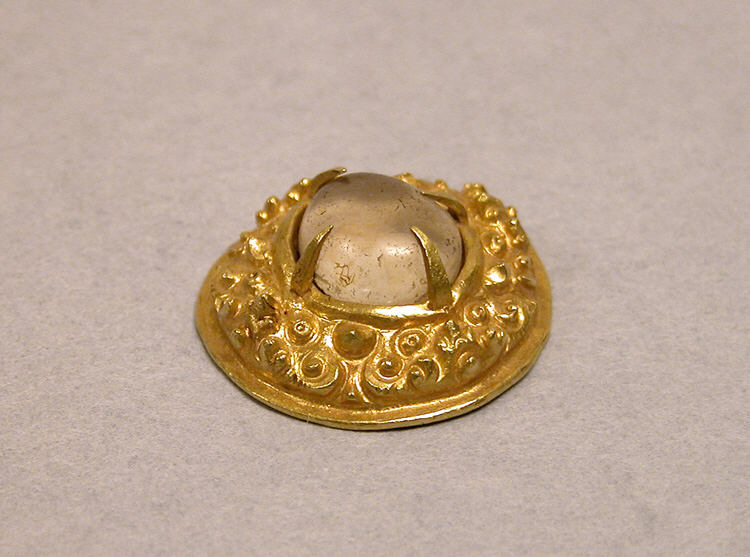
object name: ornament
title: Ornament with Crystal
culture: indonesian, central java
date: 701-1200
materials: gold